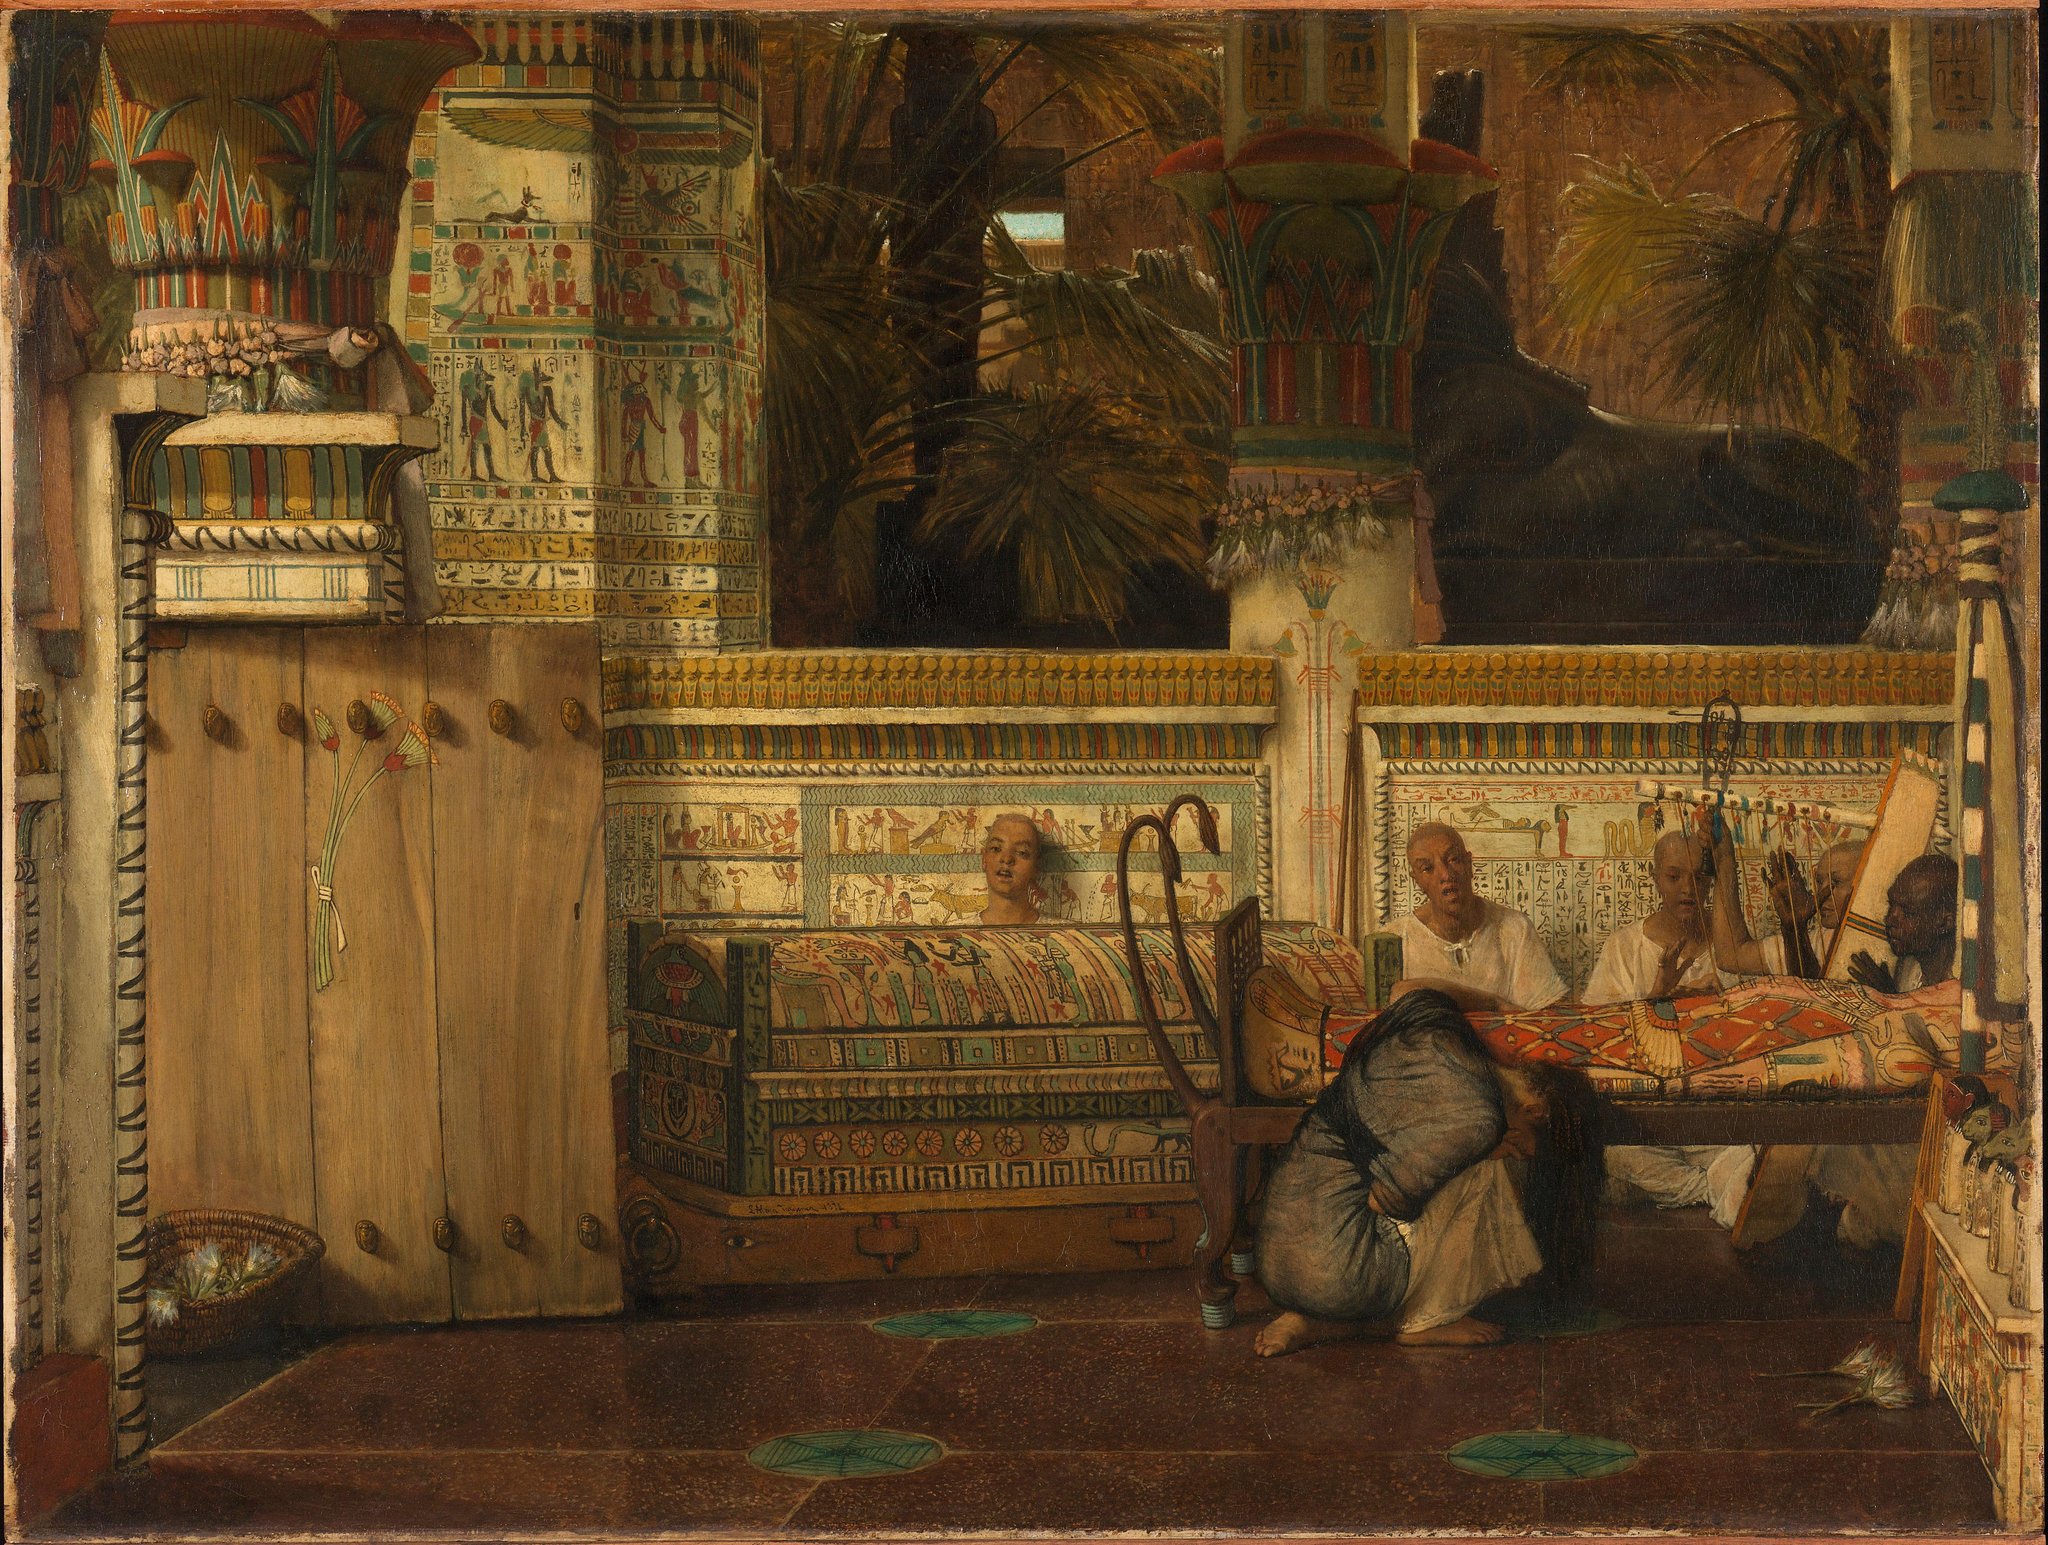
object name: painting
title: The Egyptian Widow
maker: lourens alma tadema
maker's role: draughtsman, print maker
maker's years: 1836-1912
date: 1872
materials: oil, panel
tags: widow, mourning the dead, egyptian religion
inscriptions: signature and date: ‘L. Alma Tadema 1872’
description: The Frisian artist Alma-Tadema was a great success in England, where he was even knighted. His representations of ancient Egyptian, Greek and Roman scenes made him one of the most popular 19th-century painters. In this picture, full of archaeological details, a woman is mourning beside the inner mummy case containing the body of her husband. His sarcophagus stands at left, while priests and singers lament the departed.